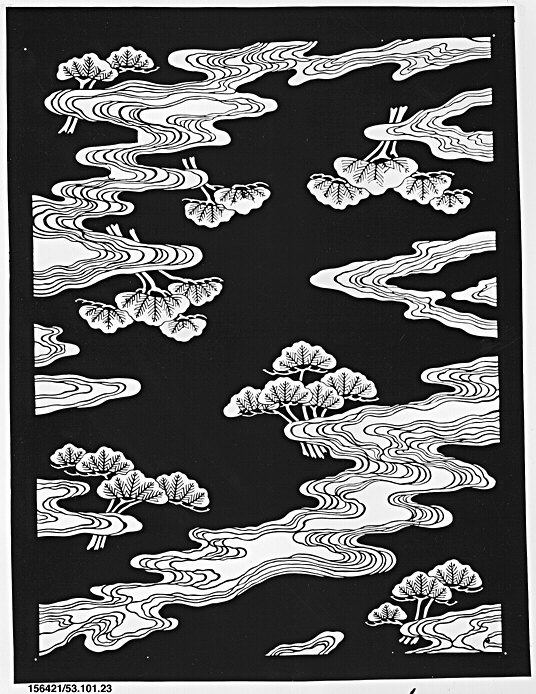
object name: stencil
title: Stencil with Pattern of Pines with Streams or Mist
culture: japanese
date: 1801-1900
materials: paper, silk